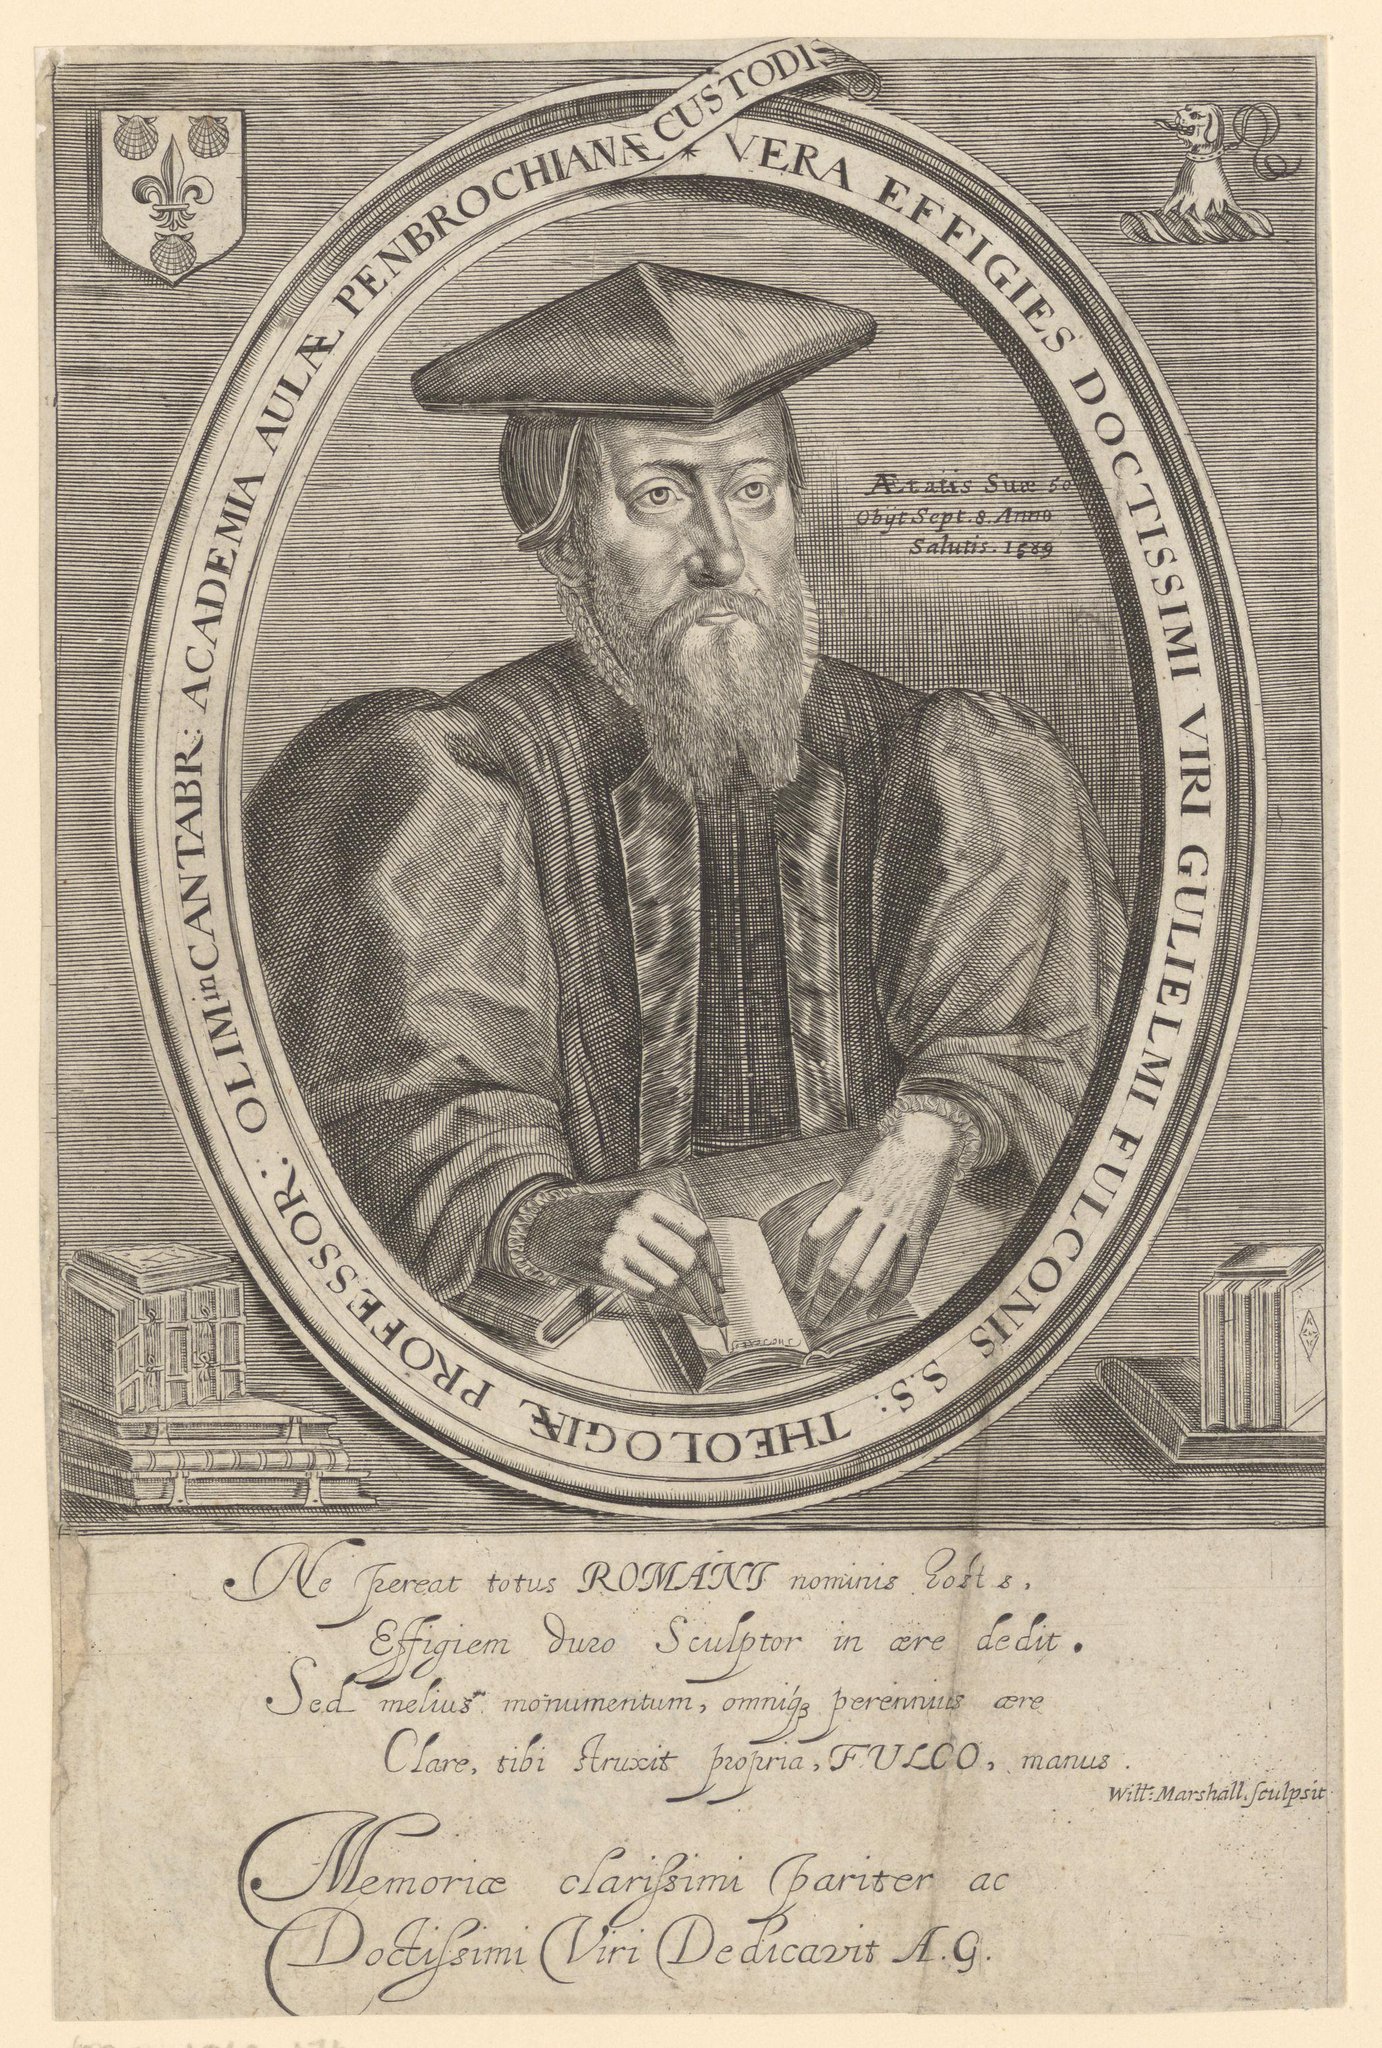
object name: print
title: Portret van William Fulke op 50-jarige leeftijd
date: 1633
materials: paper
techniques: engraving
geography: london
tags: historical persons, portrait of a writer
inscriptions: collector's mark: Lugt 2228, collector's mark: Lugt 2760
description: Prent gebruikt in: Fulke, William. The Text of the New Testament of Jesus Christ. Londen: Augustine Matthews, 1633.